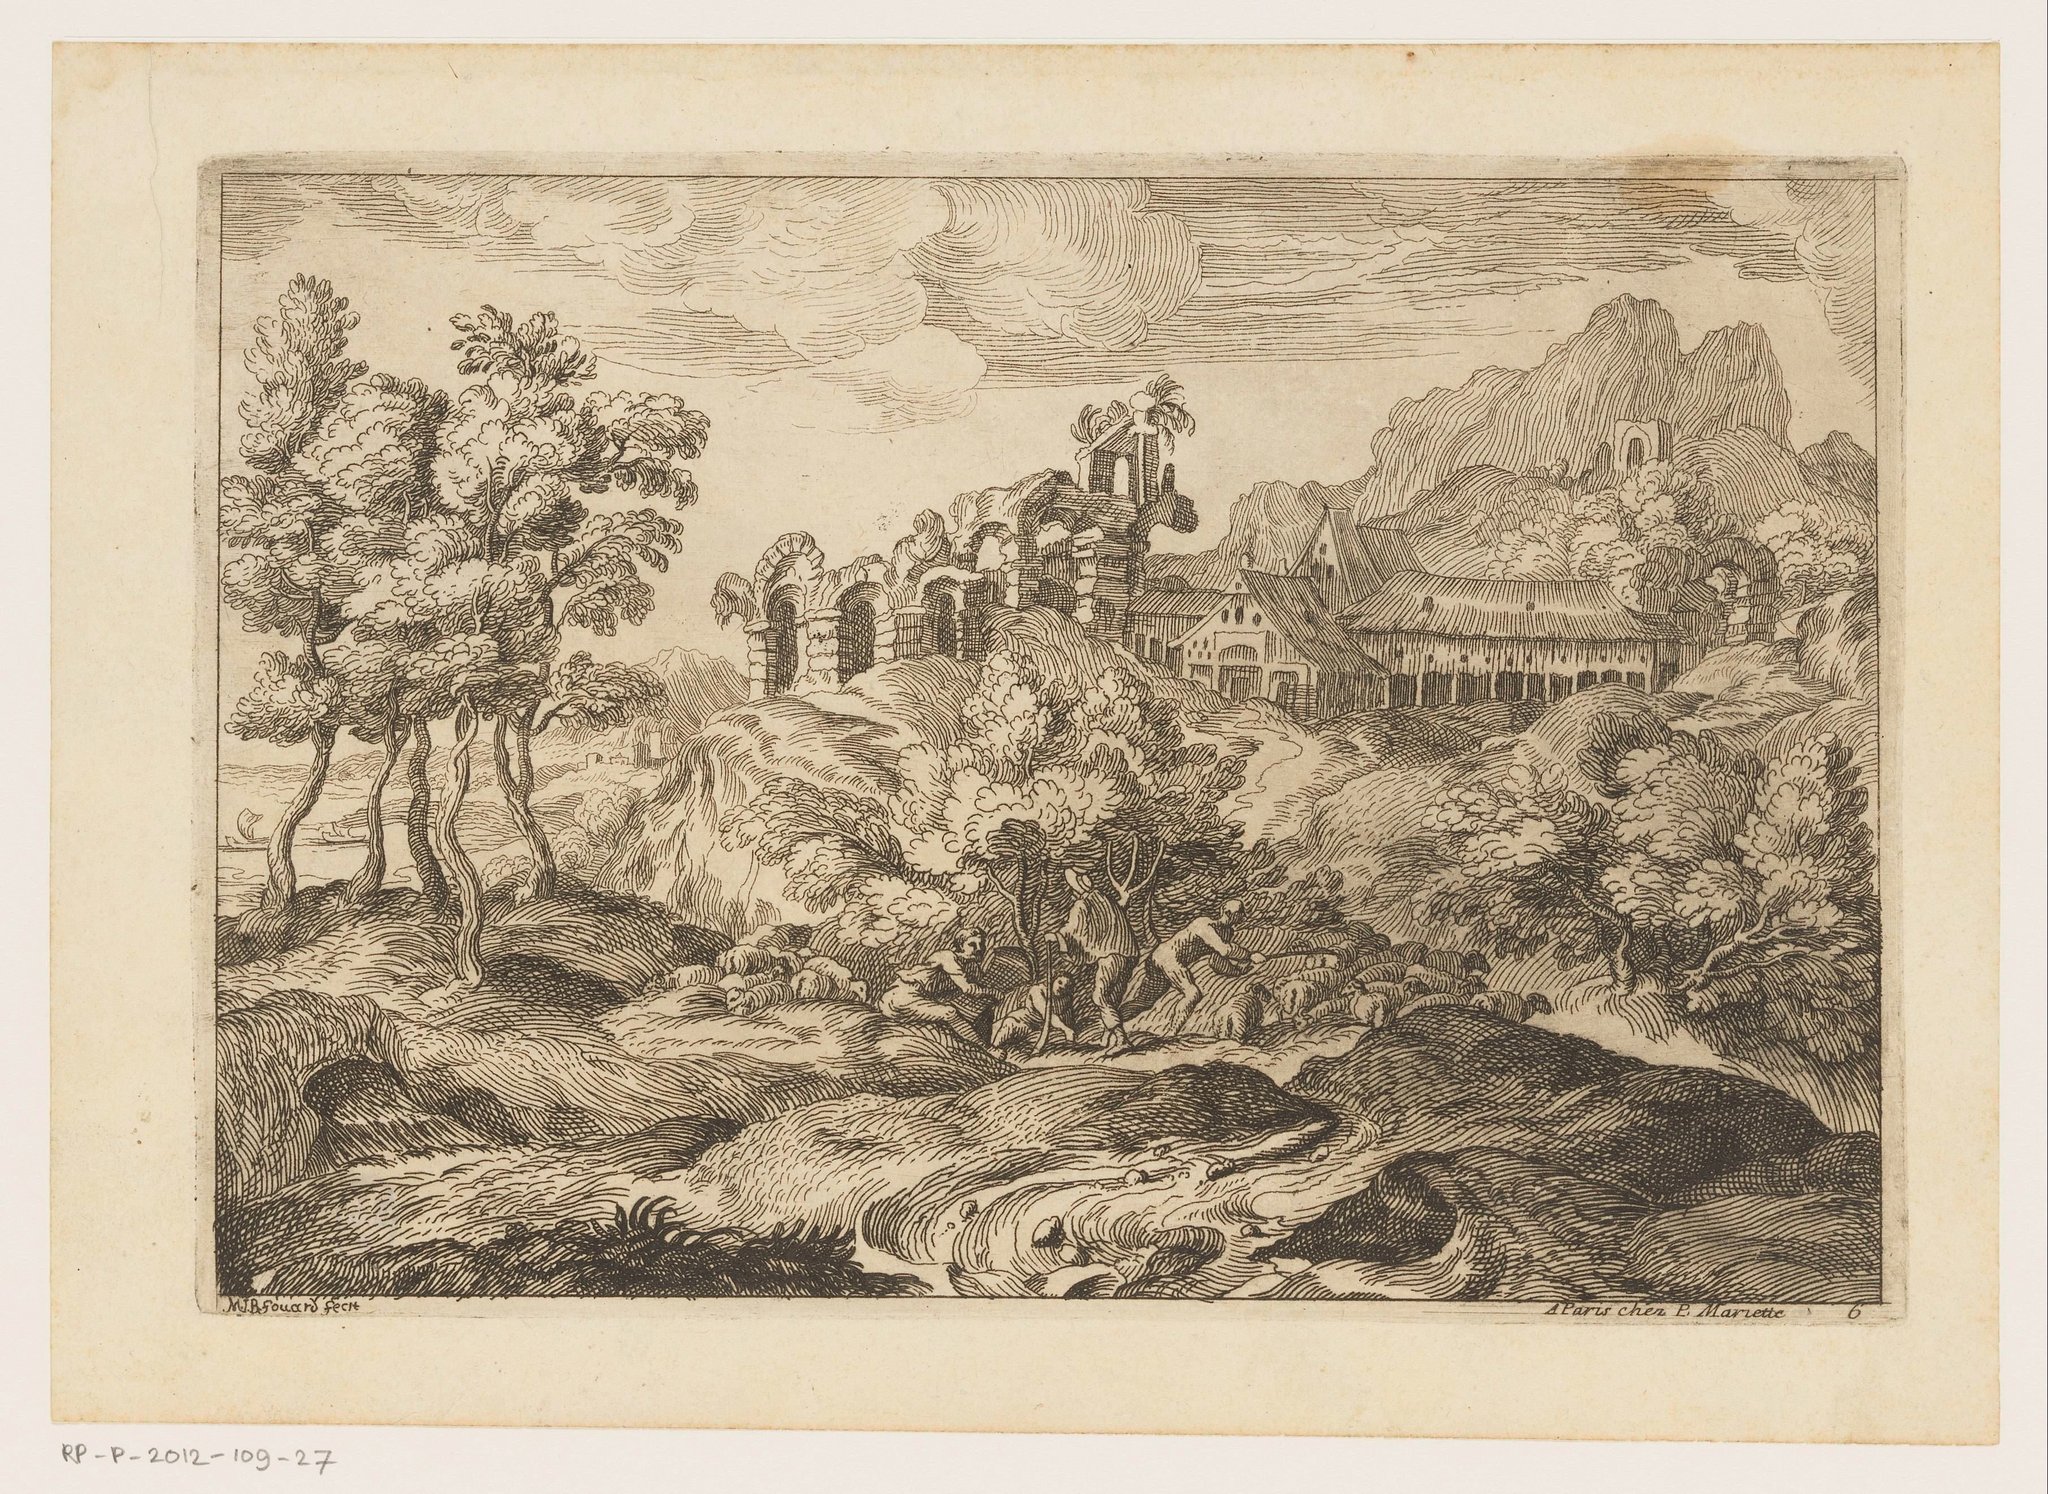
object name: print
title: Landschap met herders met een kudde bij een ruïne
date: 1663-1726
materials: paper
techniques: etching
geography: paris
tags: herding, herdsman, herdswoman, shepherd, shepherdess, cowherd, etc., landscape with ruins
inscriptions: collector's mark: Lugt 3474, collector's mark: Lugt 3473, collector's mark: Lugt 2228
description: Maakt deel uit van vierentwintigdelige serie met landschappen naar Titiaan en Campagnola.